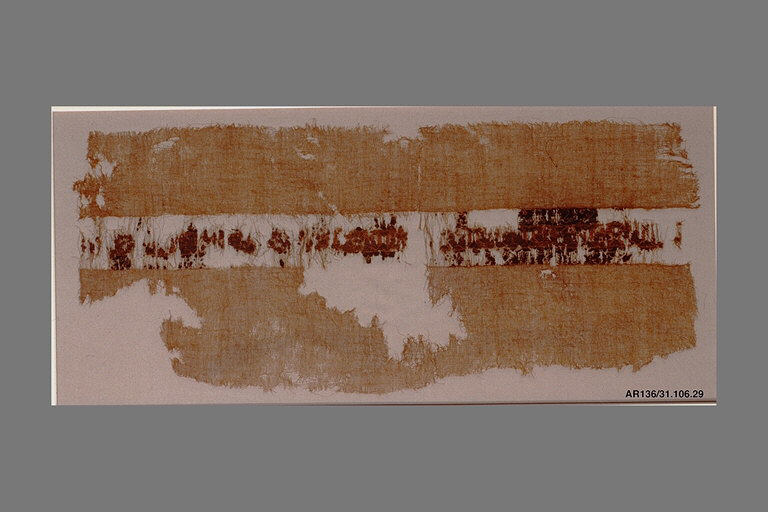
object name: textile fragment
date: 1001-1100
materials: linen, silk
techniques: weave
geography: egypt